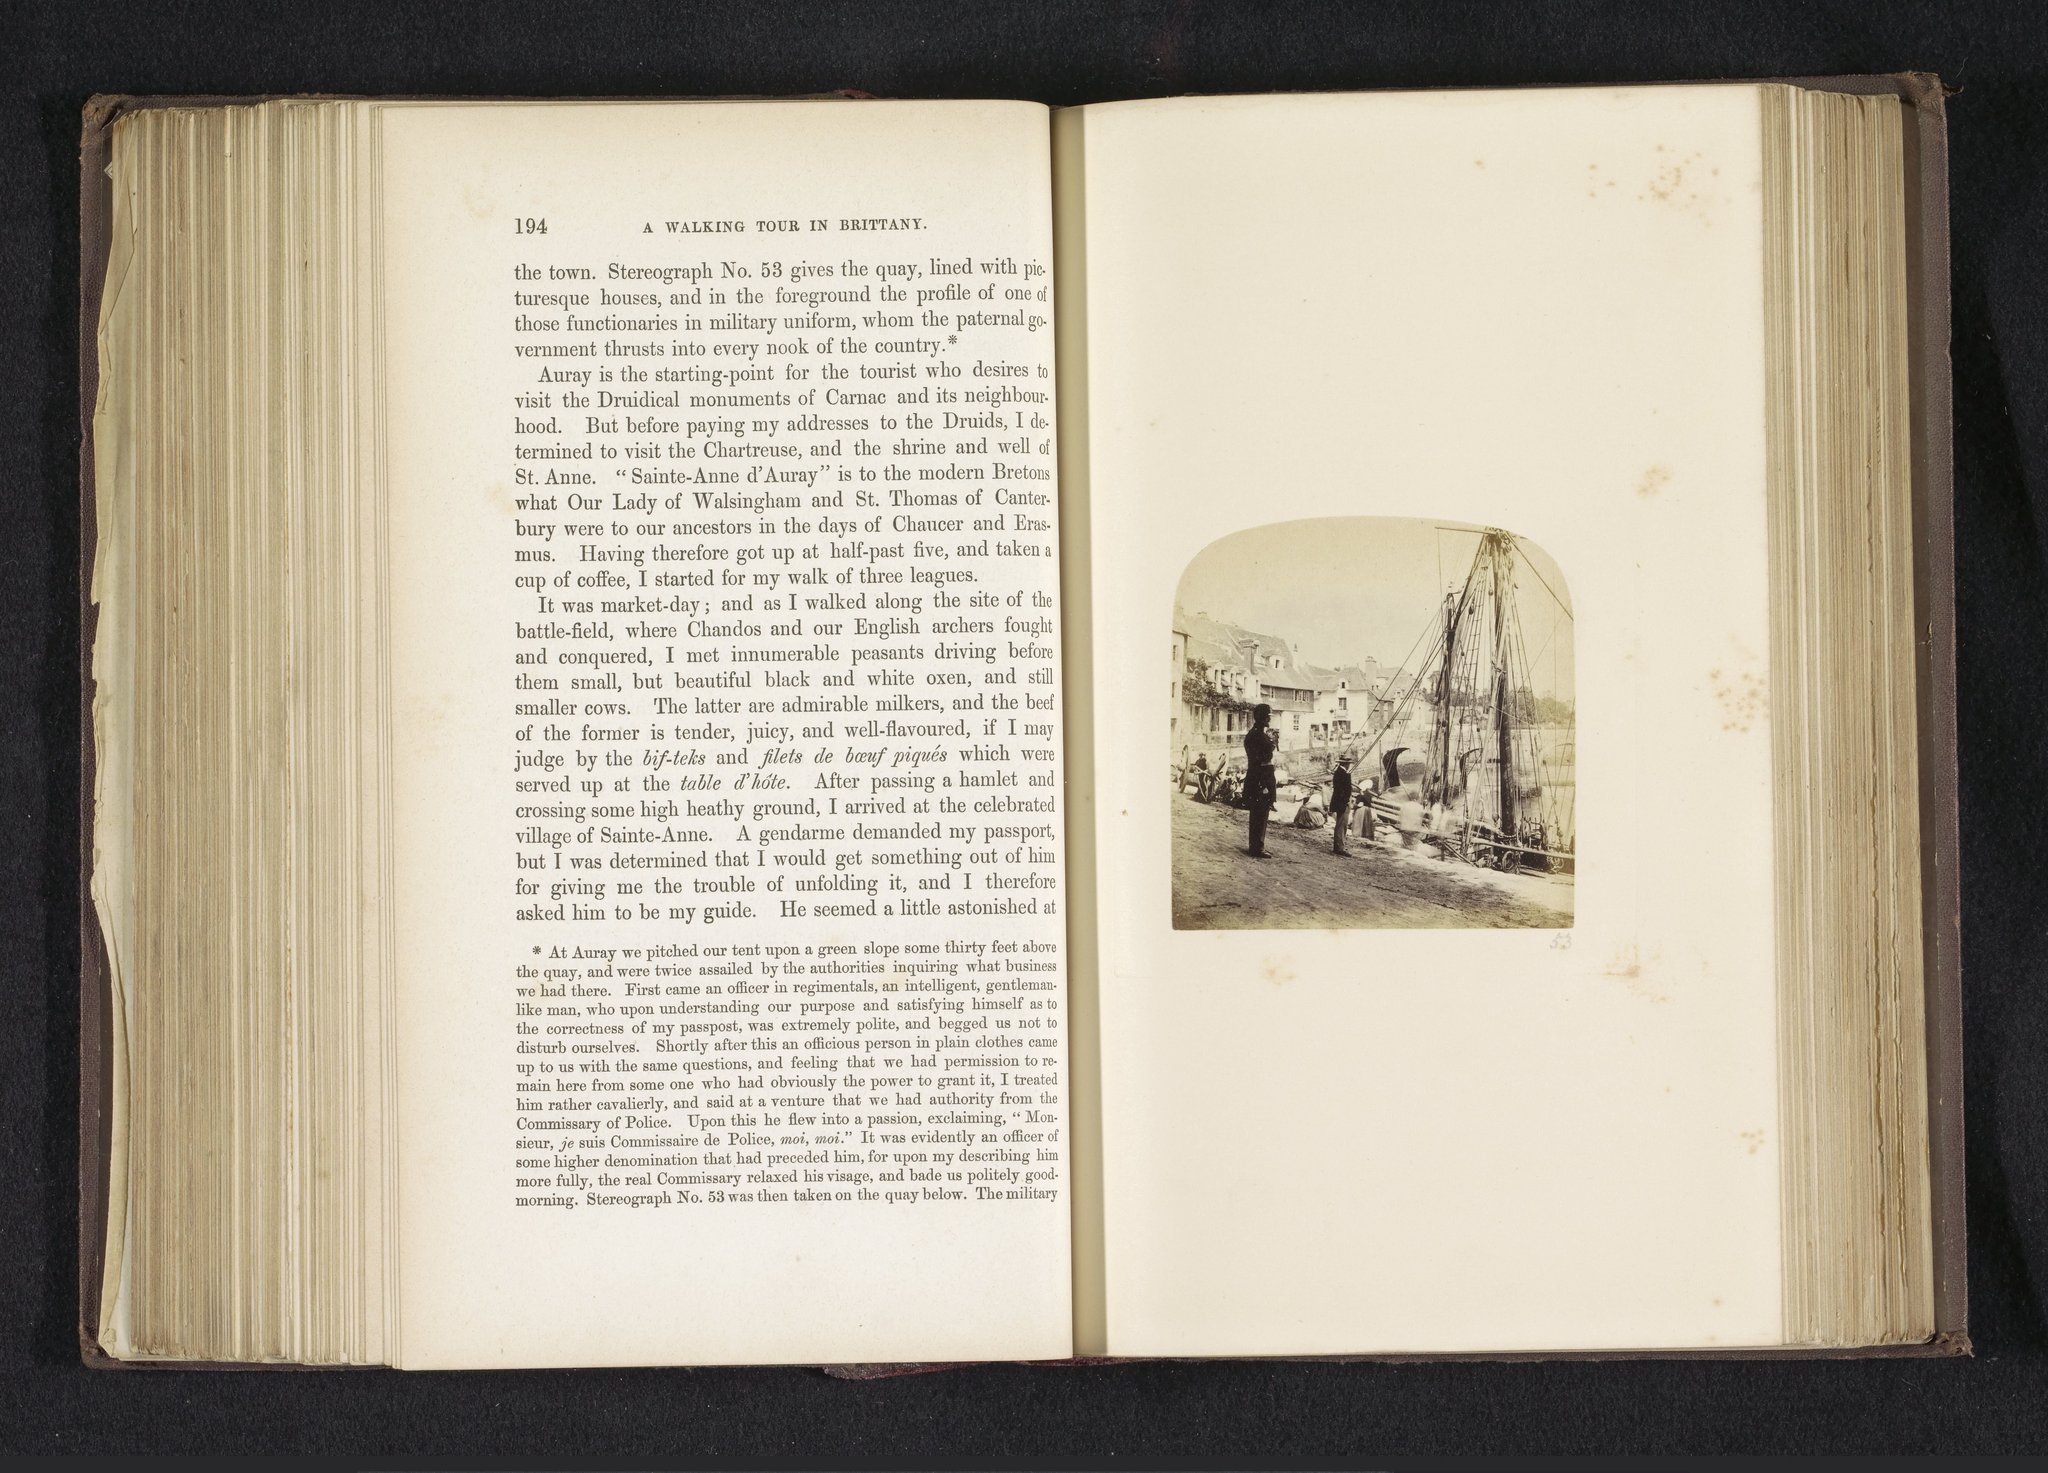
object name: page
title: Mensen bij een schip aan de kade te Auray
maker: taylor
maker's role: fotograaf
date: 1850-1859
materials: photographic support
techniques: albumen print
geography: auray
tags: sailing-ship, sailing-boat, quay (+ city(-scape) with figures, staffage)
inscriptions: number: ‘53’